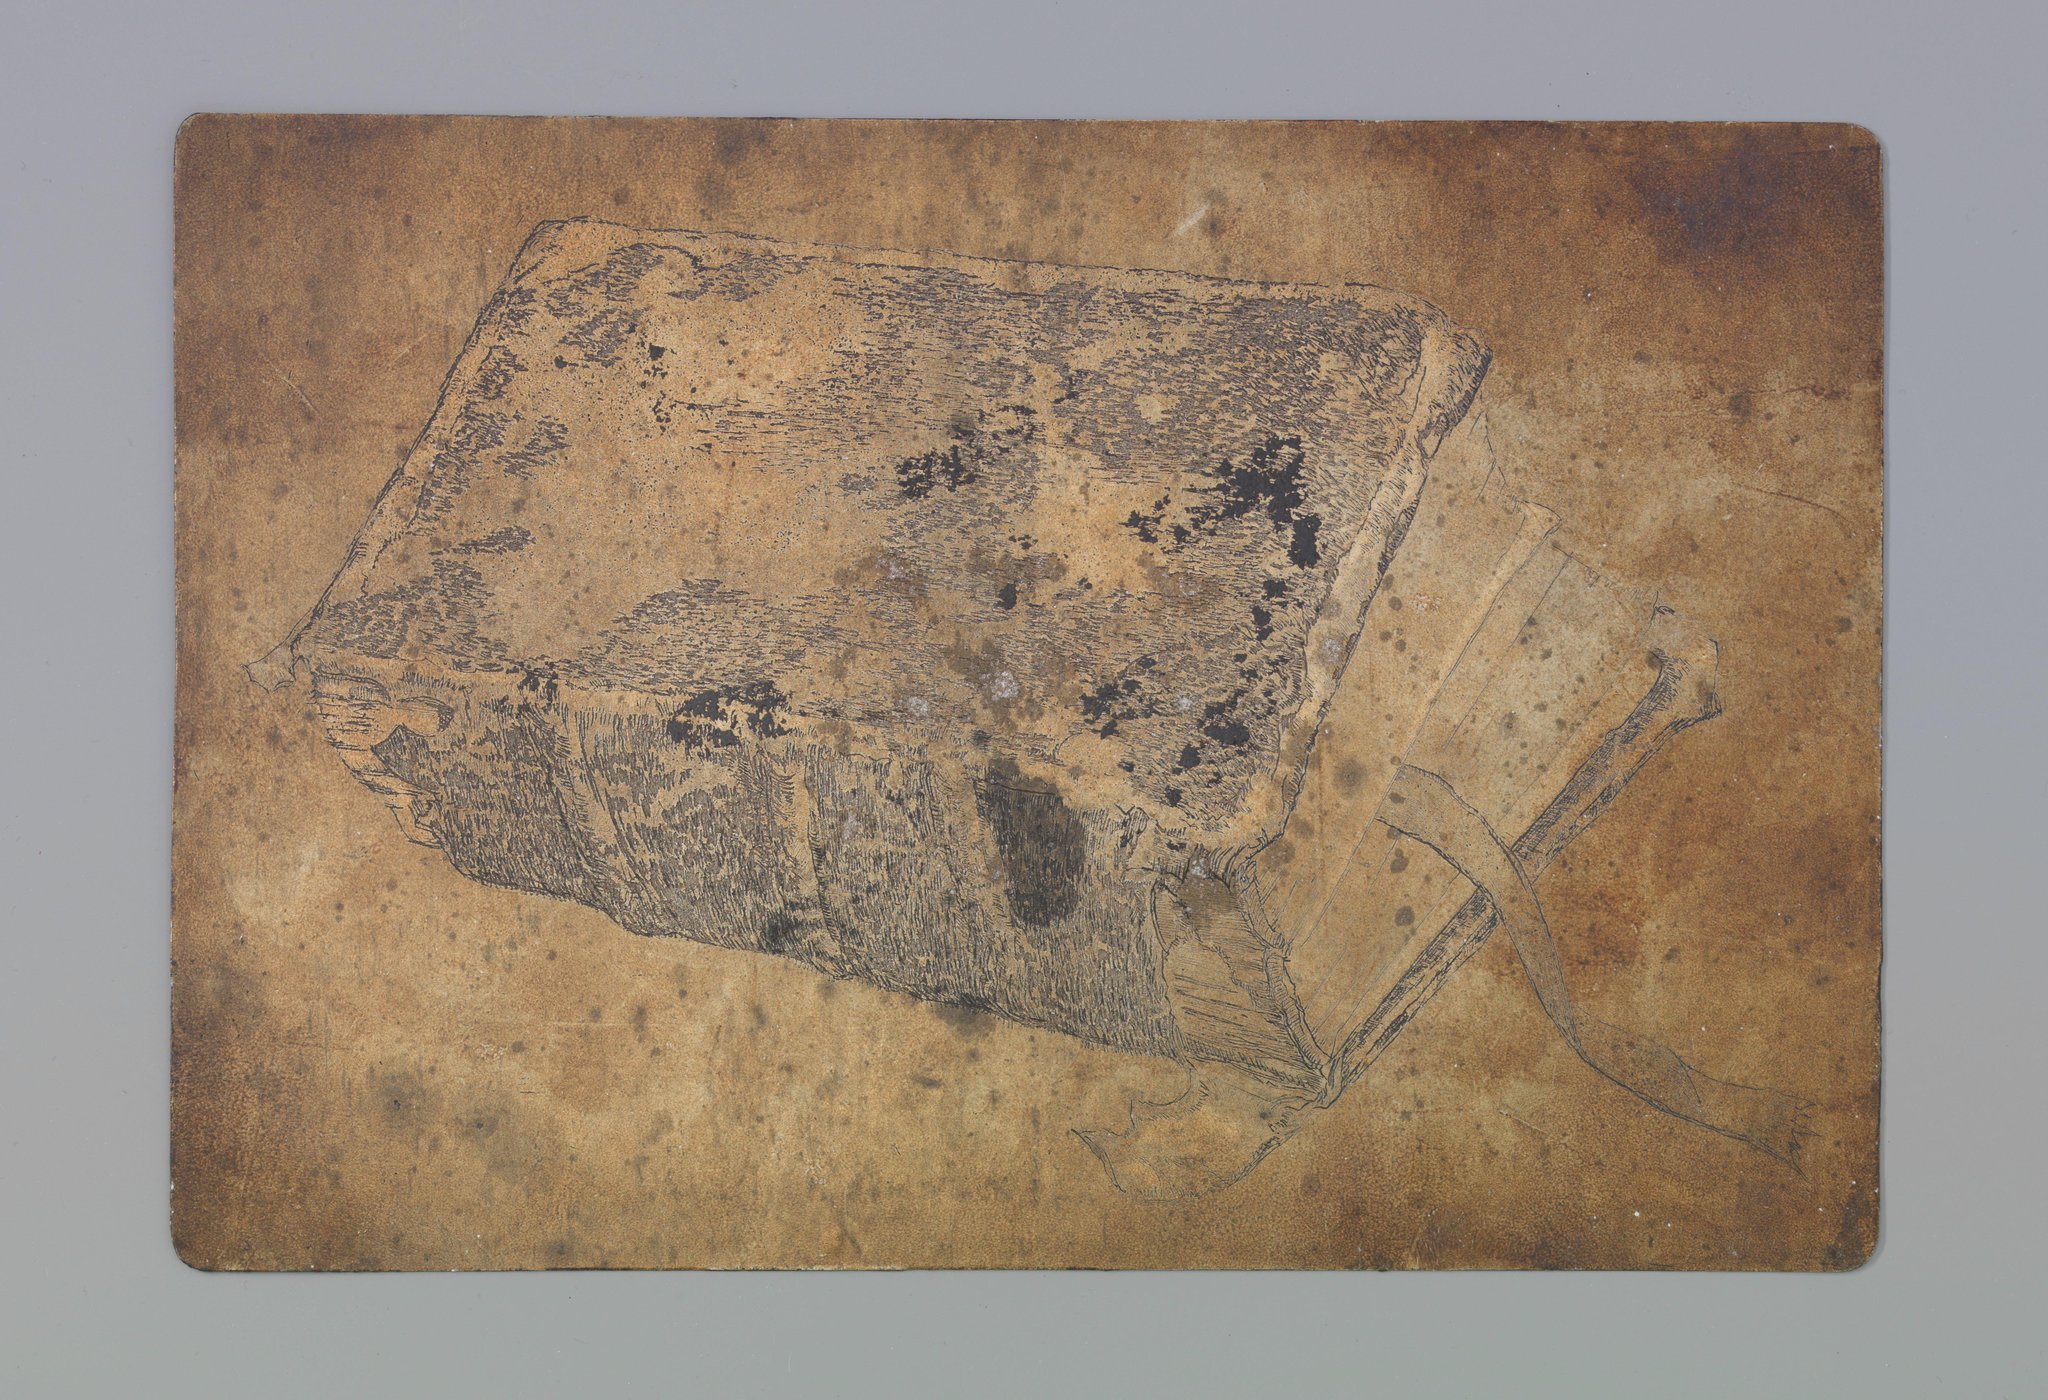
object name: messingplaat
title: Oud boekje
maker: jan petrus ponstijn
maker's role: draughtsman, print maker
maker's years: 1883-1970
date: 1946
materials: brass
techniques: etching